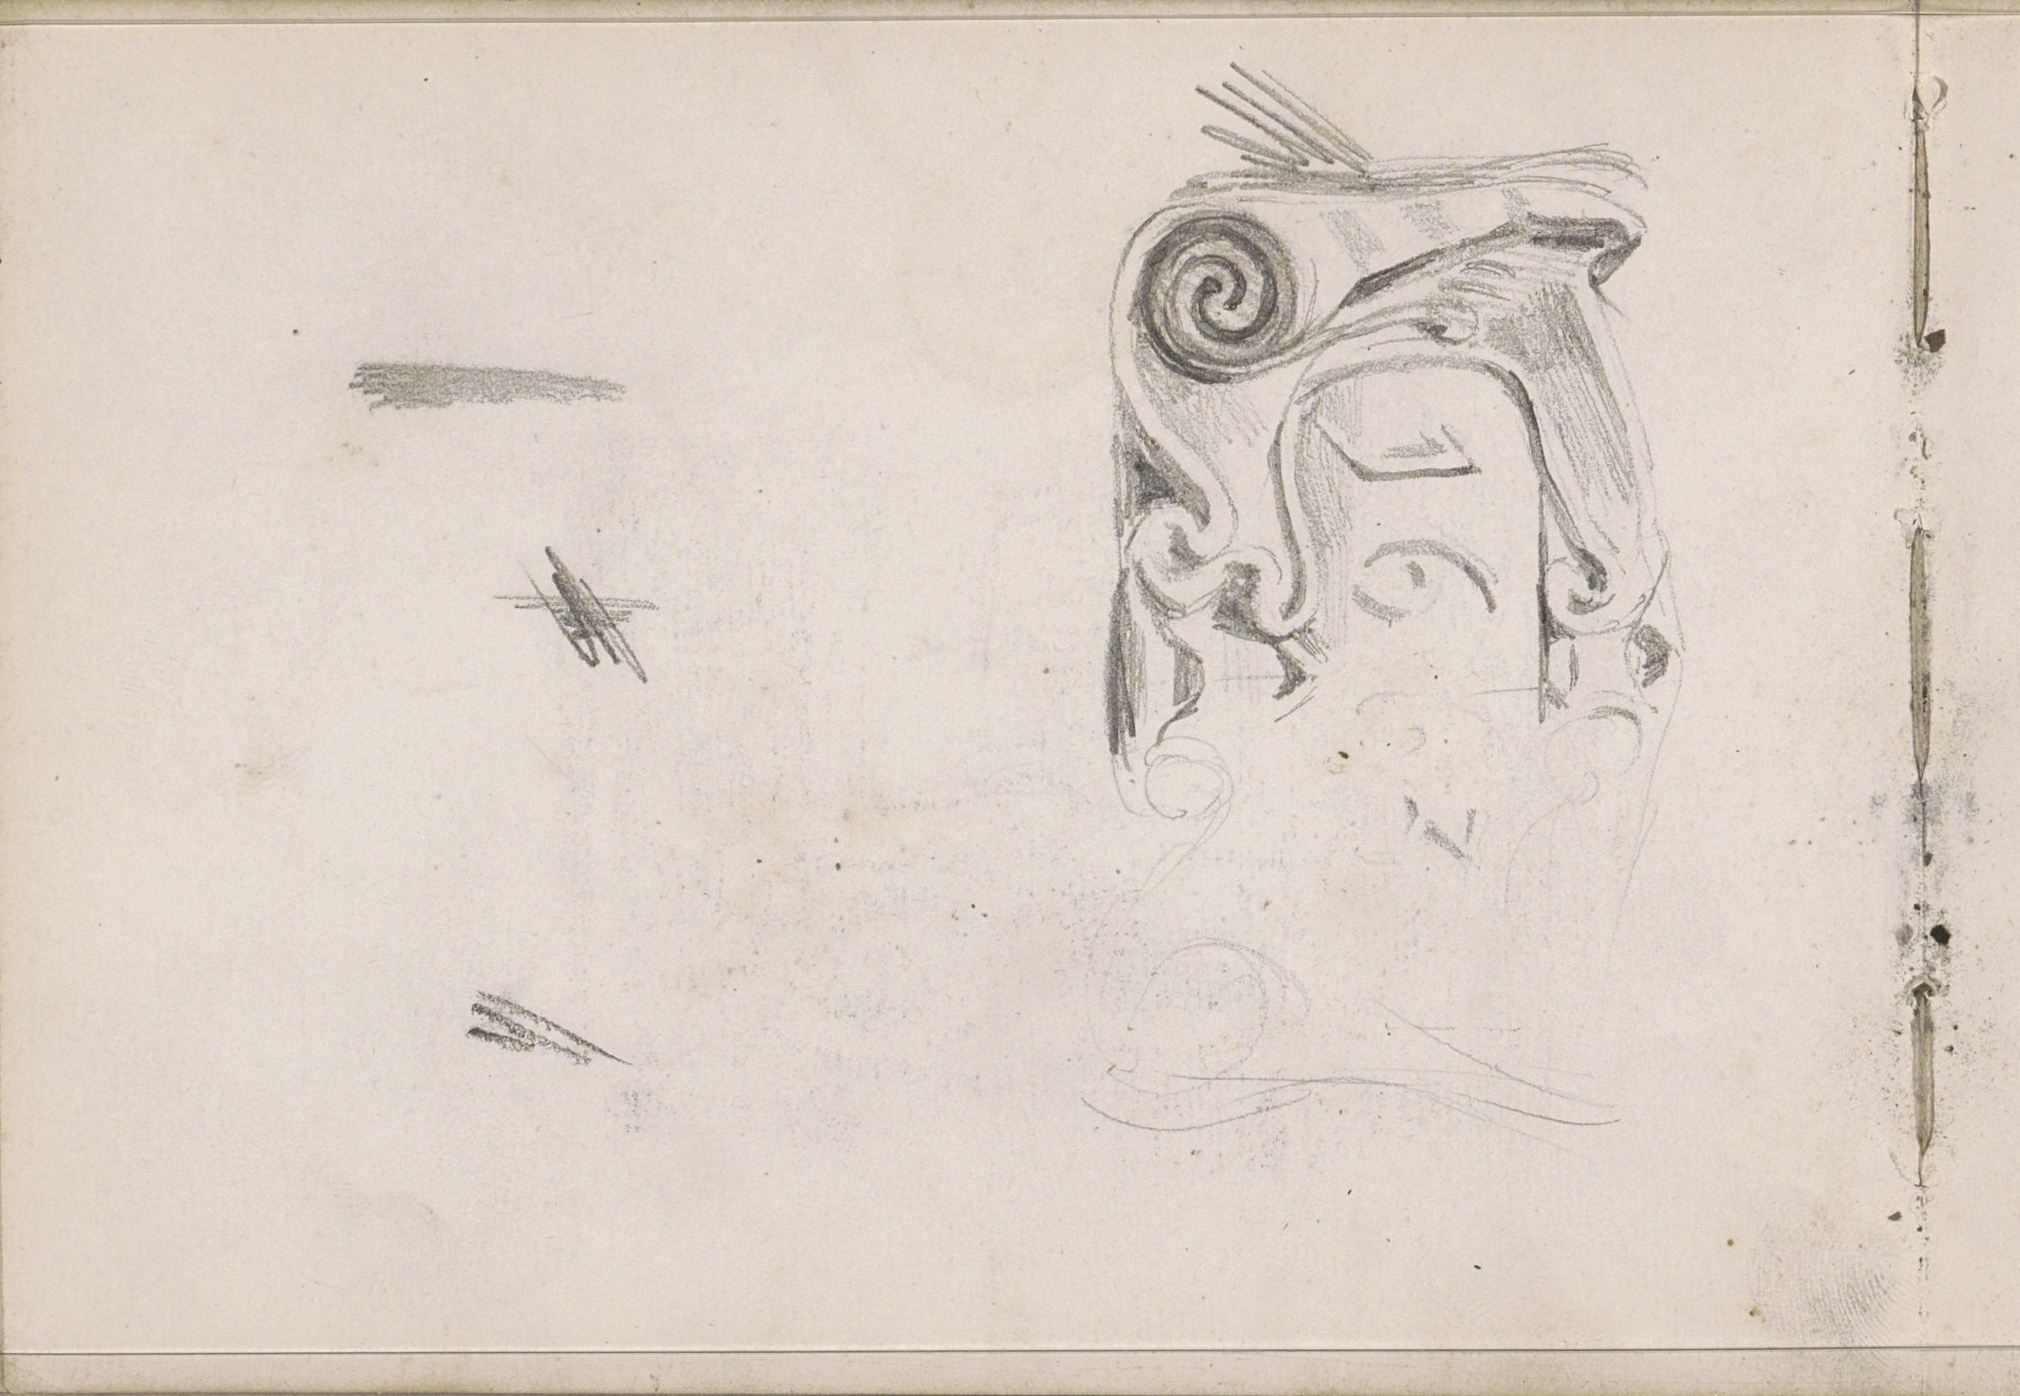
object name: sketchbook leaf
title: Gevelsteen met jaartal in cartouche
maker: jac van looij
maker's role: draughtsman, painter, print maker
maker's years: 1855-1930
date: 1877-1880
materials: paper, pencil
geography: amsterdam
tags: stone tablet in façade, ribbon, scroll, banderole ~ ornament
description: Gevelsteen met jaartal '16[...]' versierd met rolwerk. Blad 23 verso uit een schetsboek met 27 bladen.